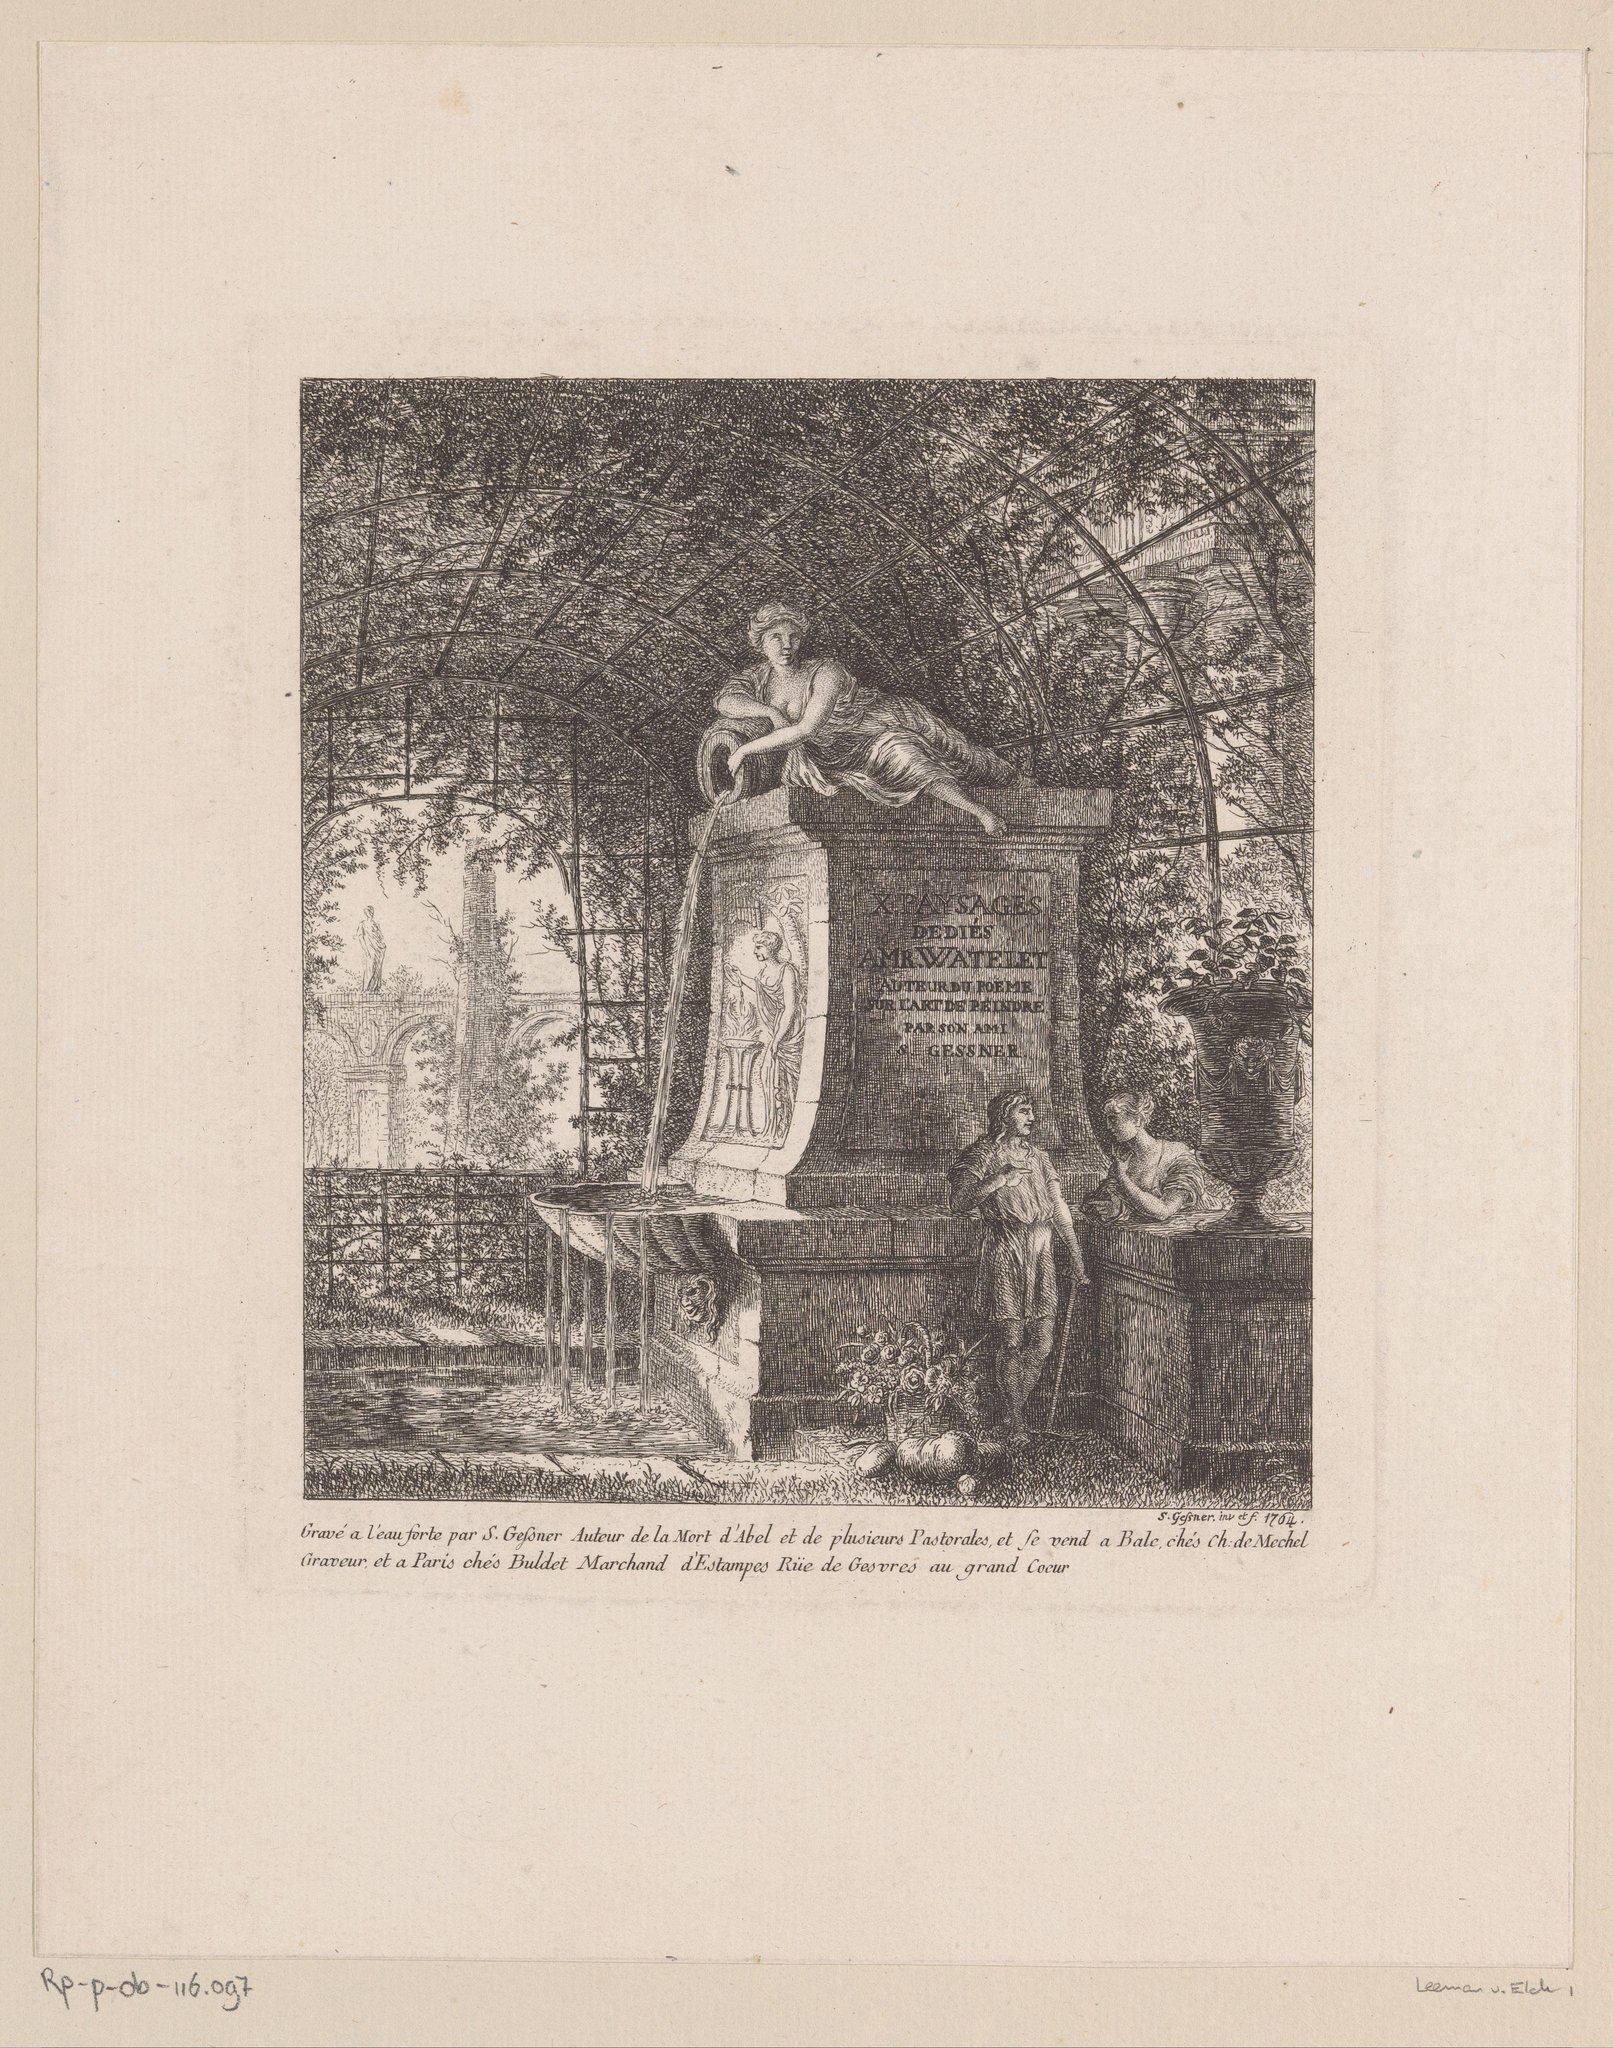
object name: titelprent, frontispice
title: Tien landschappen opgedragen aan de dichter Watelet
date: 1764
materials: paper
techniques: etching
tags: garden fountain, pergola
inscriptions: collector's mark: Lugt 240